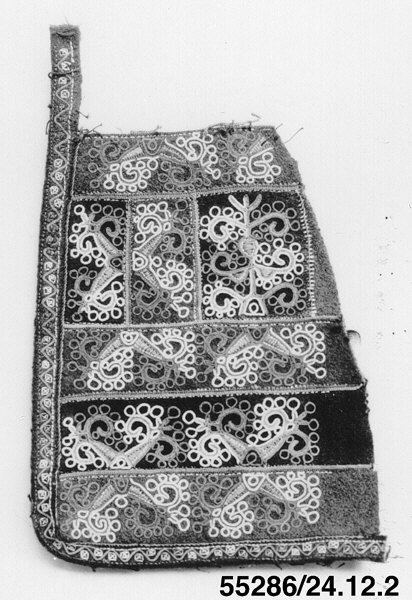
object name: pocket portion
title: Portion of a pocket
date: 1801-1900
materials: felt